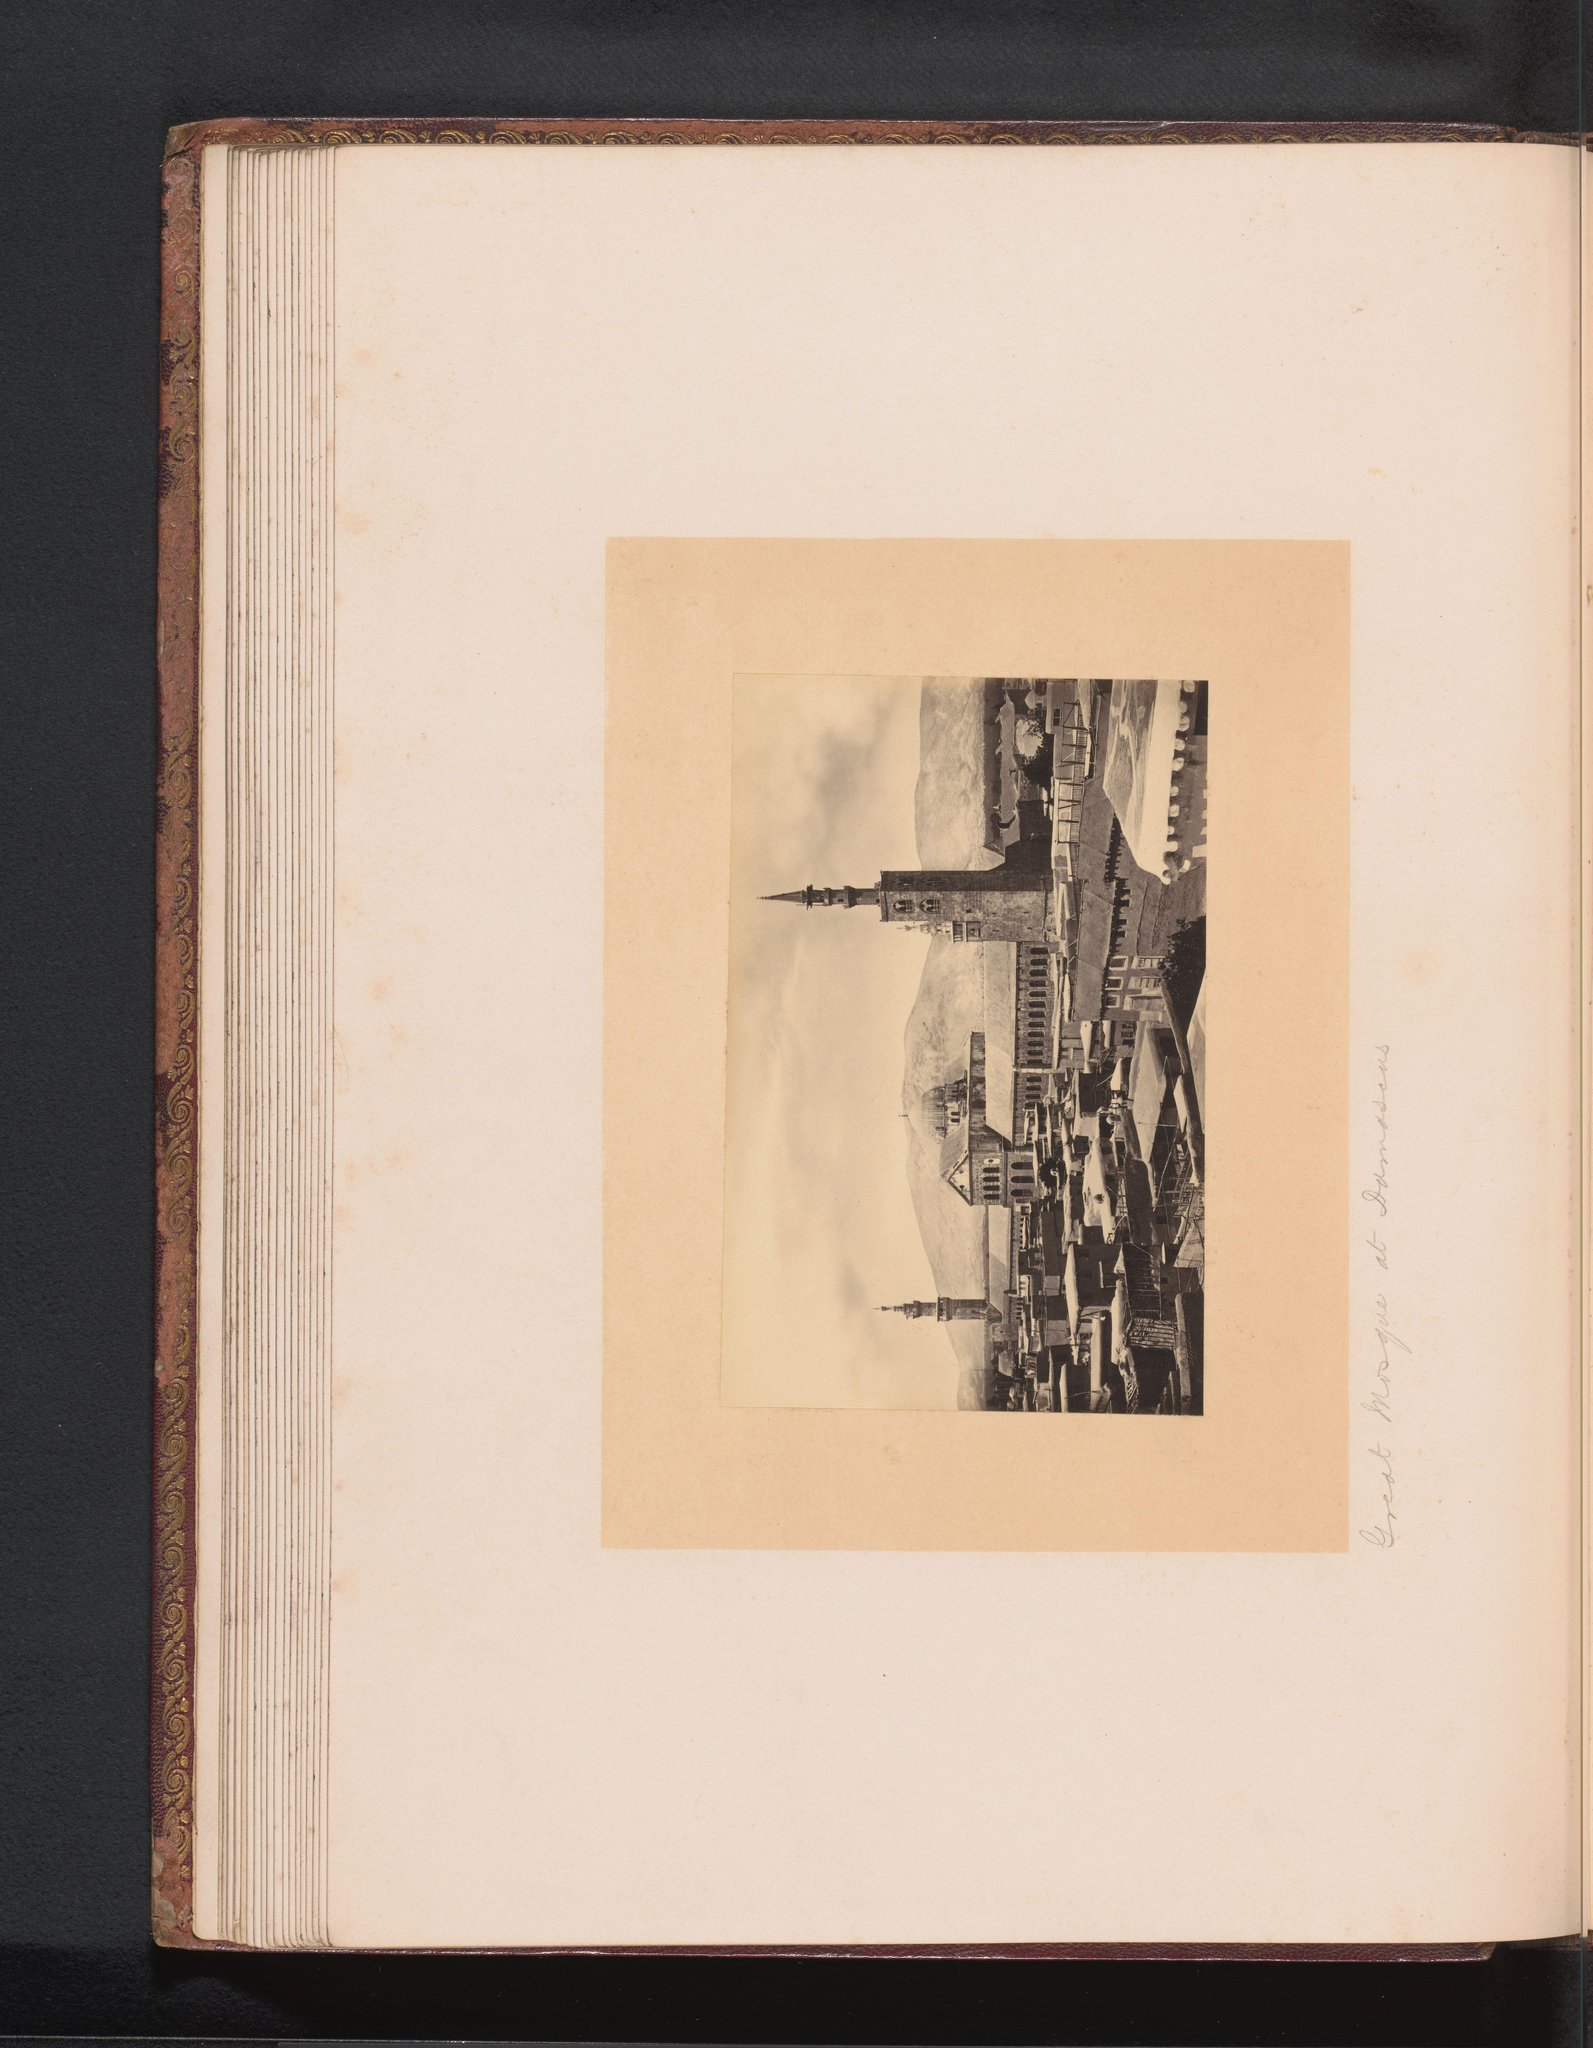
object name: photograph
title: Gezicht op de Grote moskee van Damascus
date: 1870-1875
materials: photographic support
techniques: albumen print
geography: damascus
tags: city-view in general; 'veduta', temple, shrine ~ islam, mohammedanism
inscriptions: annotation: ‘Great mosque at Damascus’